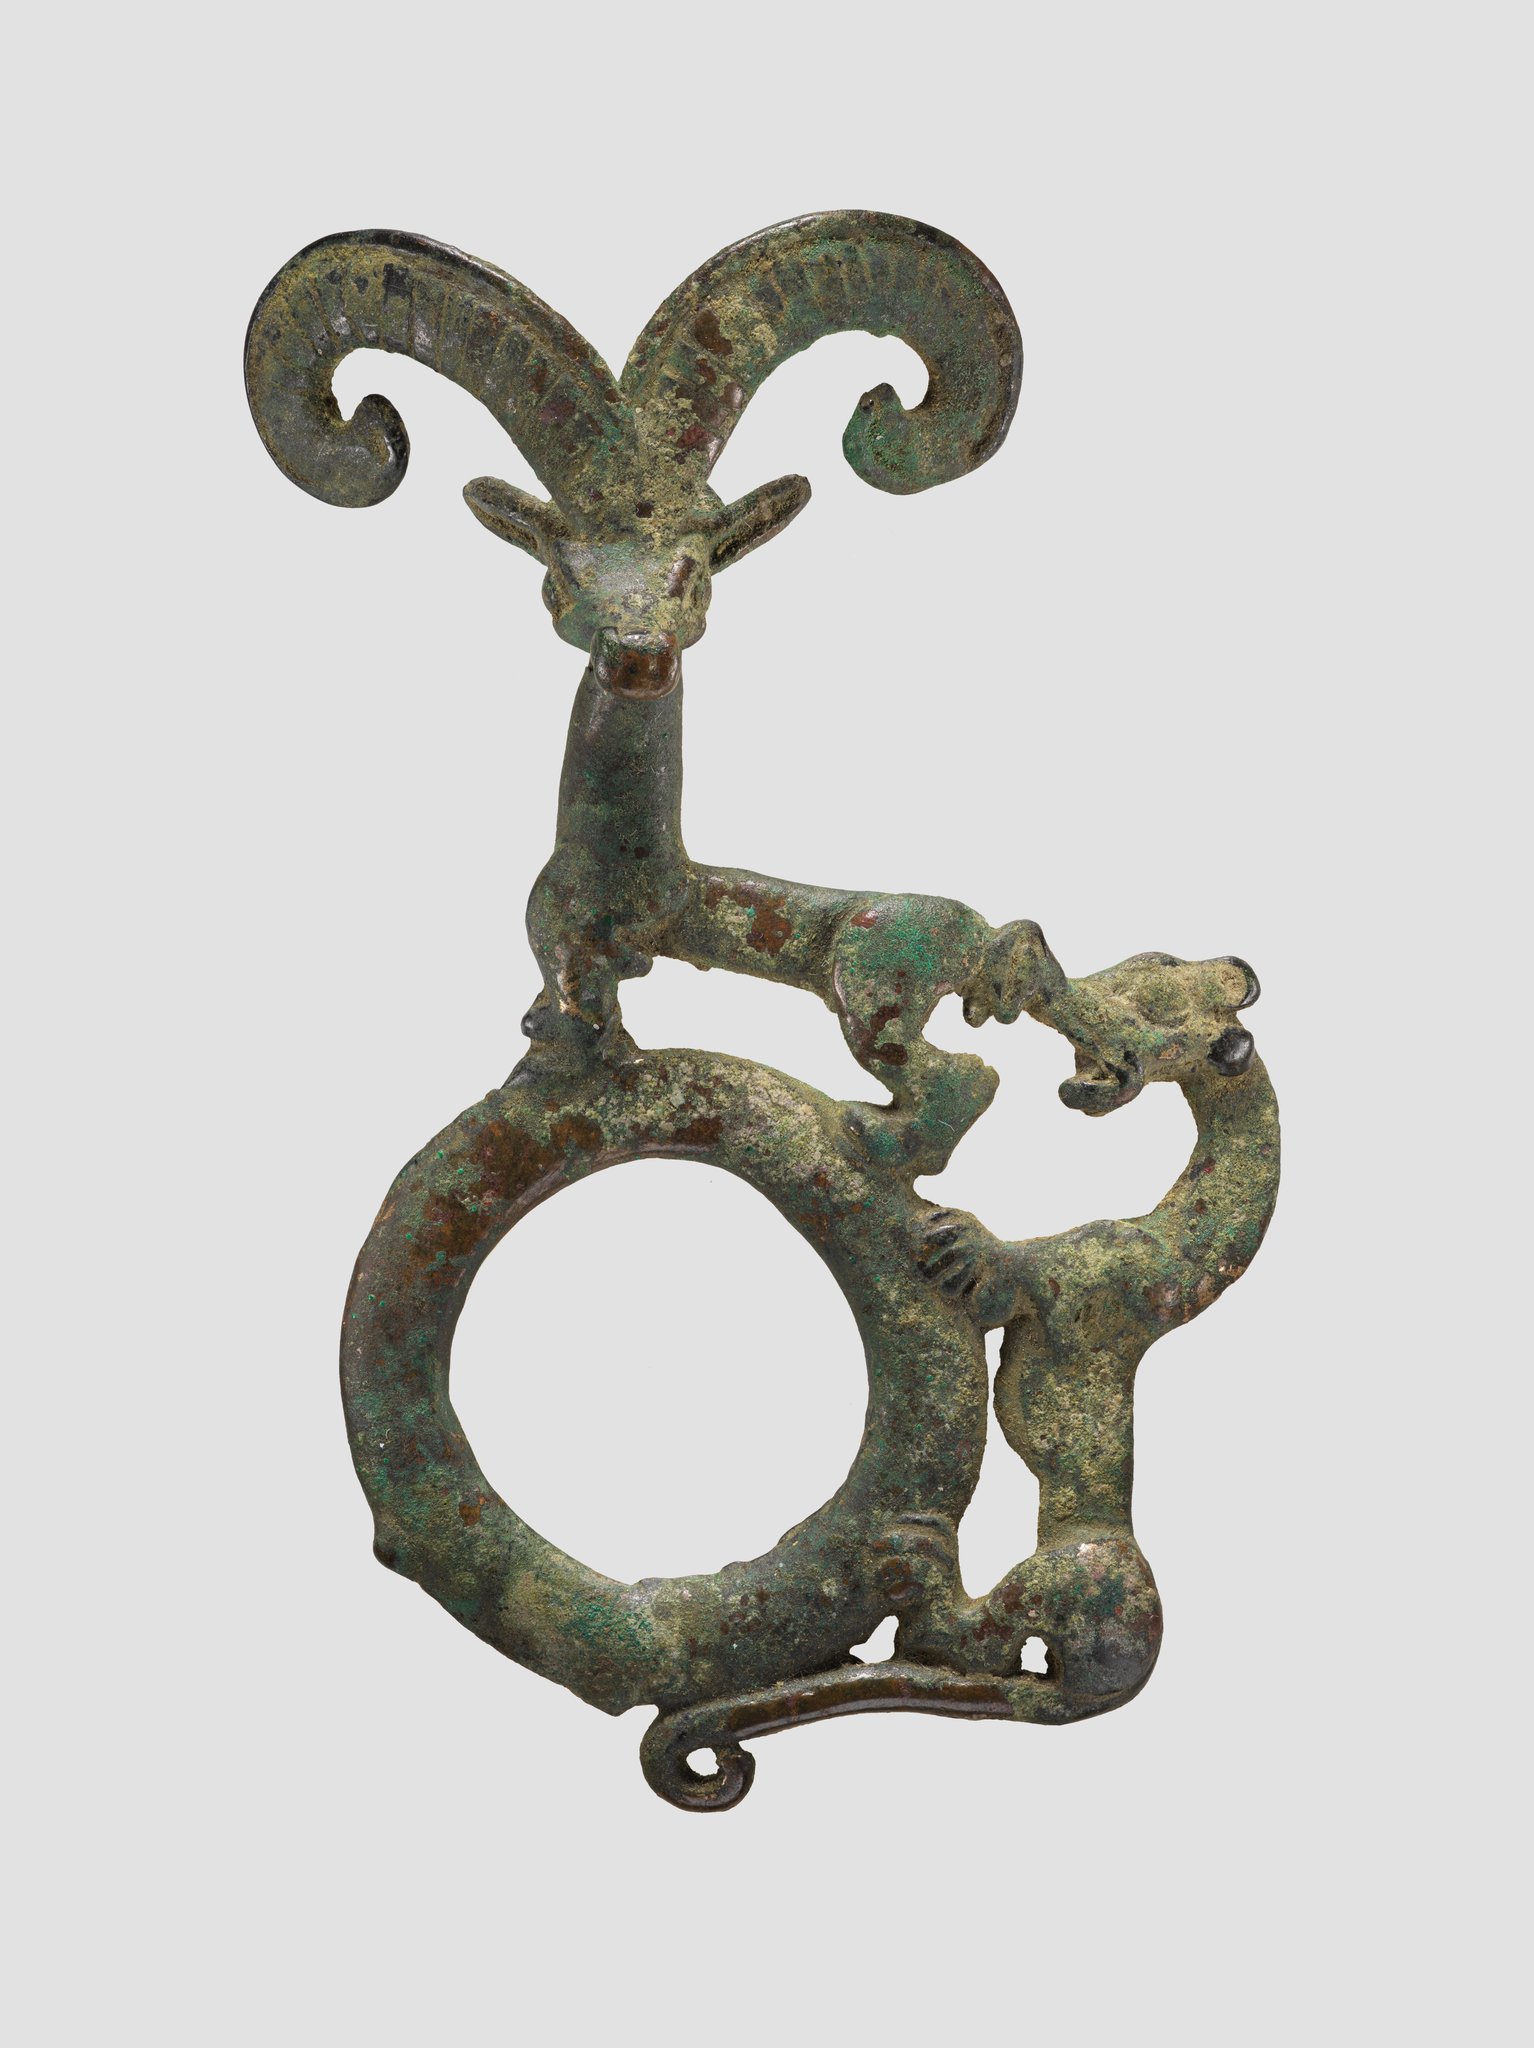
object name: harness ring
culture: iranian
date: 800-601 BCE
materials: bronze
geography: iran, probably from luristan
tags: animals